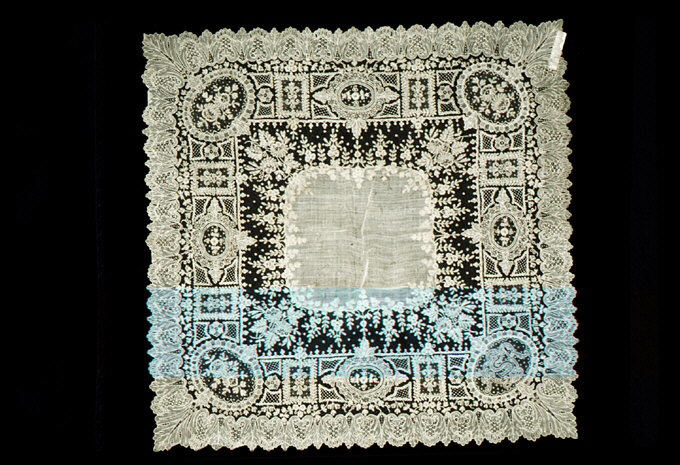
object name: handkerchief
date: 1801-1900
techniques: lace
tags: flowers